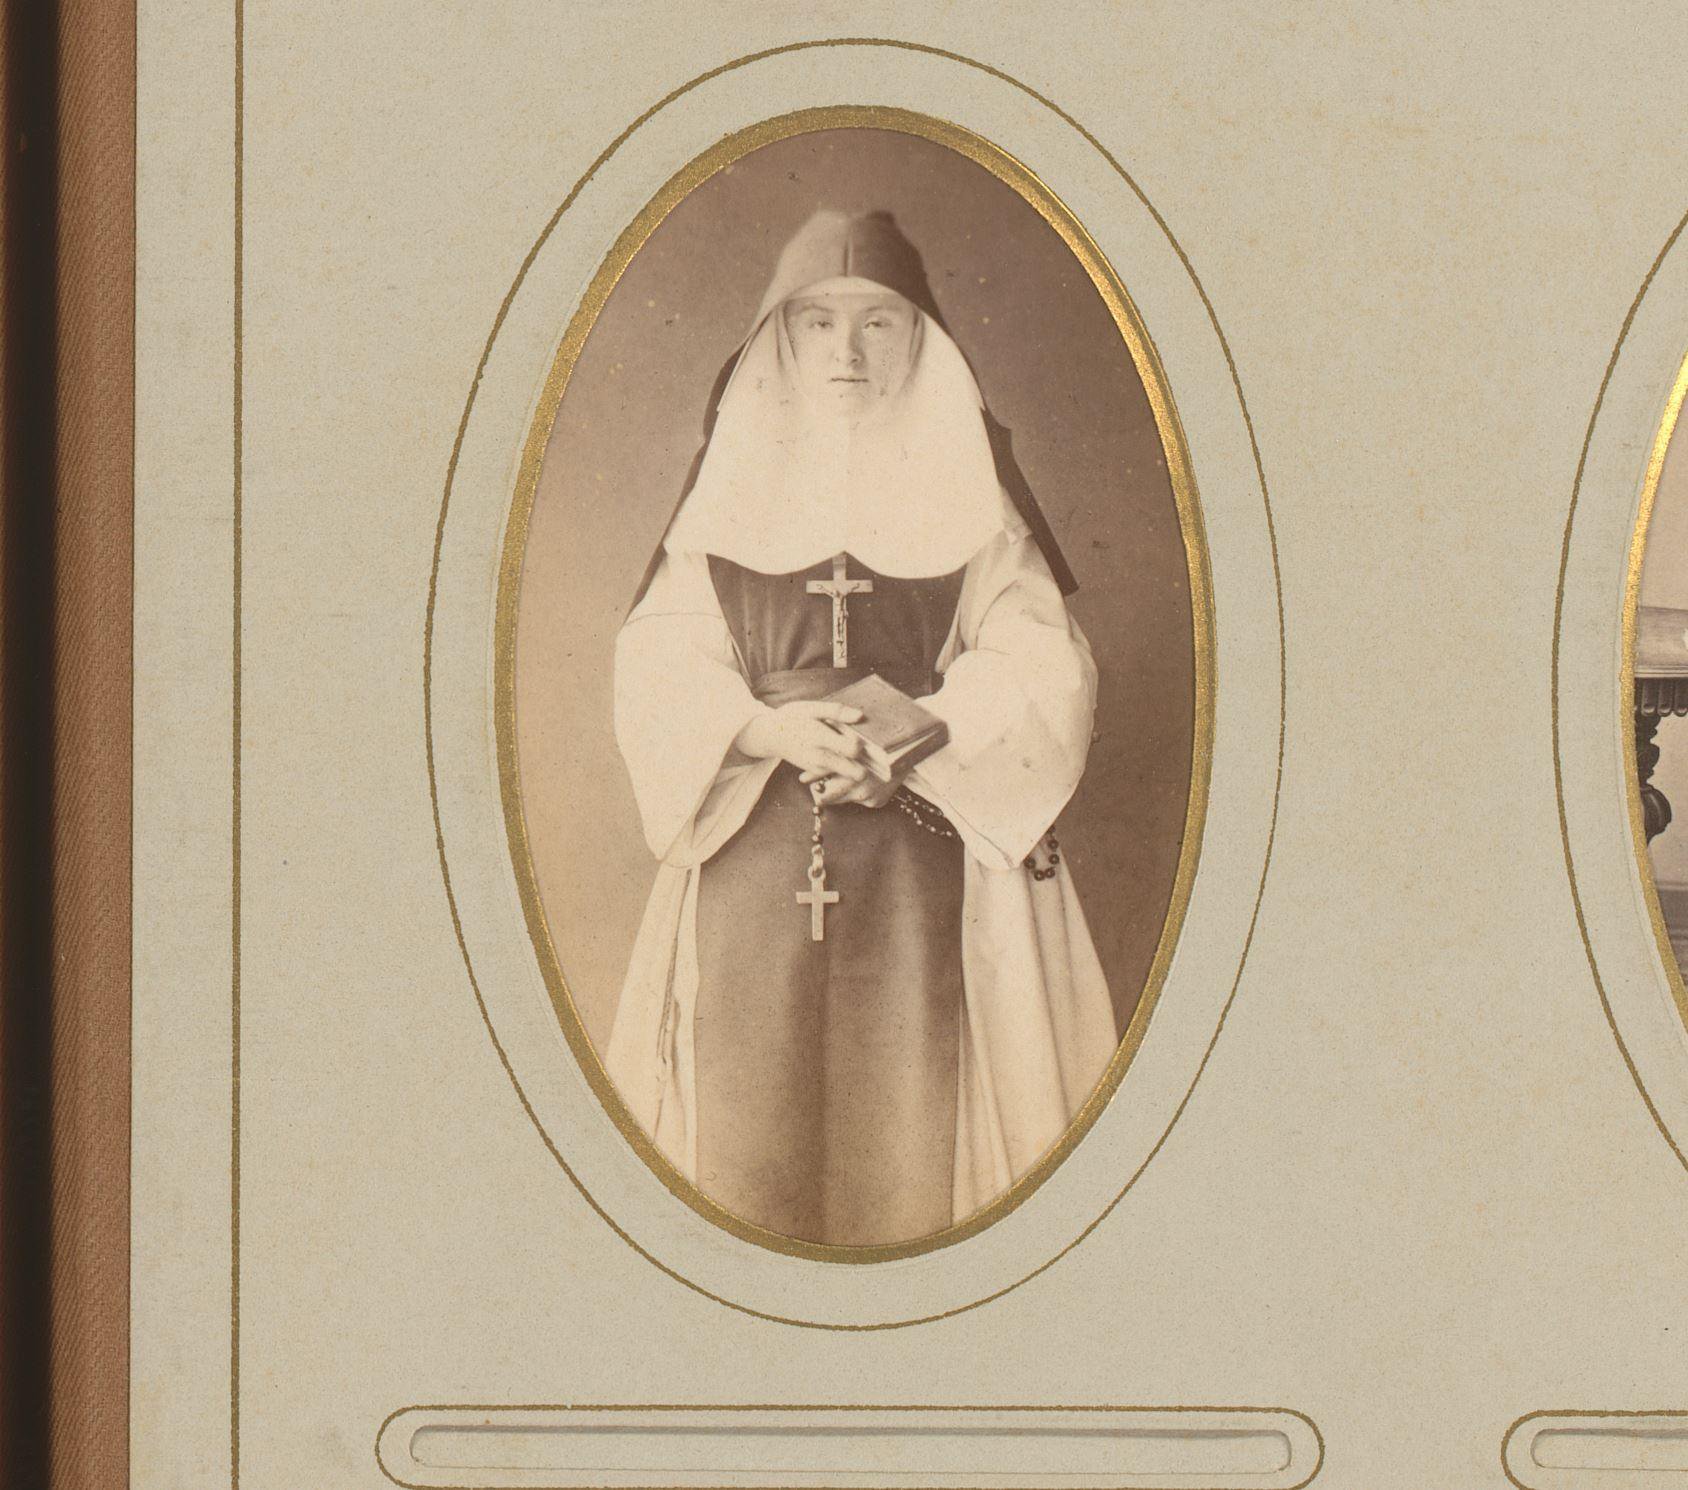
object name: photograph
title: Portret van een non met bijbel in de hand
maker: constant wante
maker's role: fotograaf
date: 1864-1901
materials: cardboard, photographic support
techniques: albumen print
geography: ghent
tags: historical persons - bb - woman, nun(s), the bible as a book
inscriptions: inscription: ‘Photographie Artistique/ rue Haute, 64, Gand./ Cst WANTE/ Peintre Photographe./ L'atelier est construit de plain pied dans un jardin,/ dont l'étendue permet de photographier chevaux et voitures,/ ainsi que les groupes les plus nombreux./ Reproduction d'anciens portraits et de toutes sortes d'objets d'art./ Portraits après décès. - Agrandissements./ PHOTOGRAPHIE AU CHARBON.’